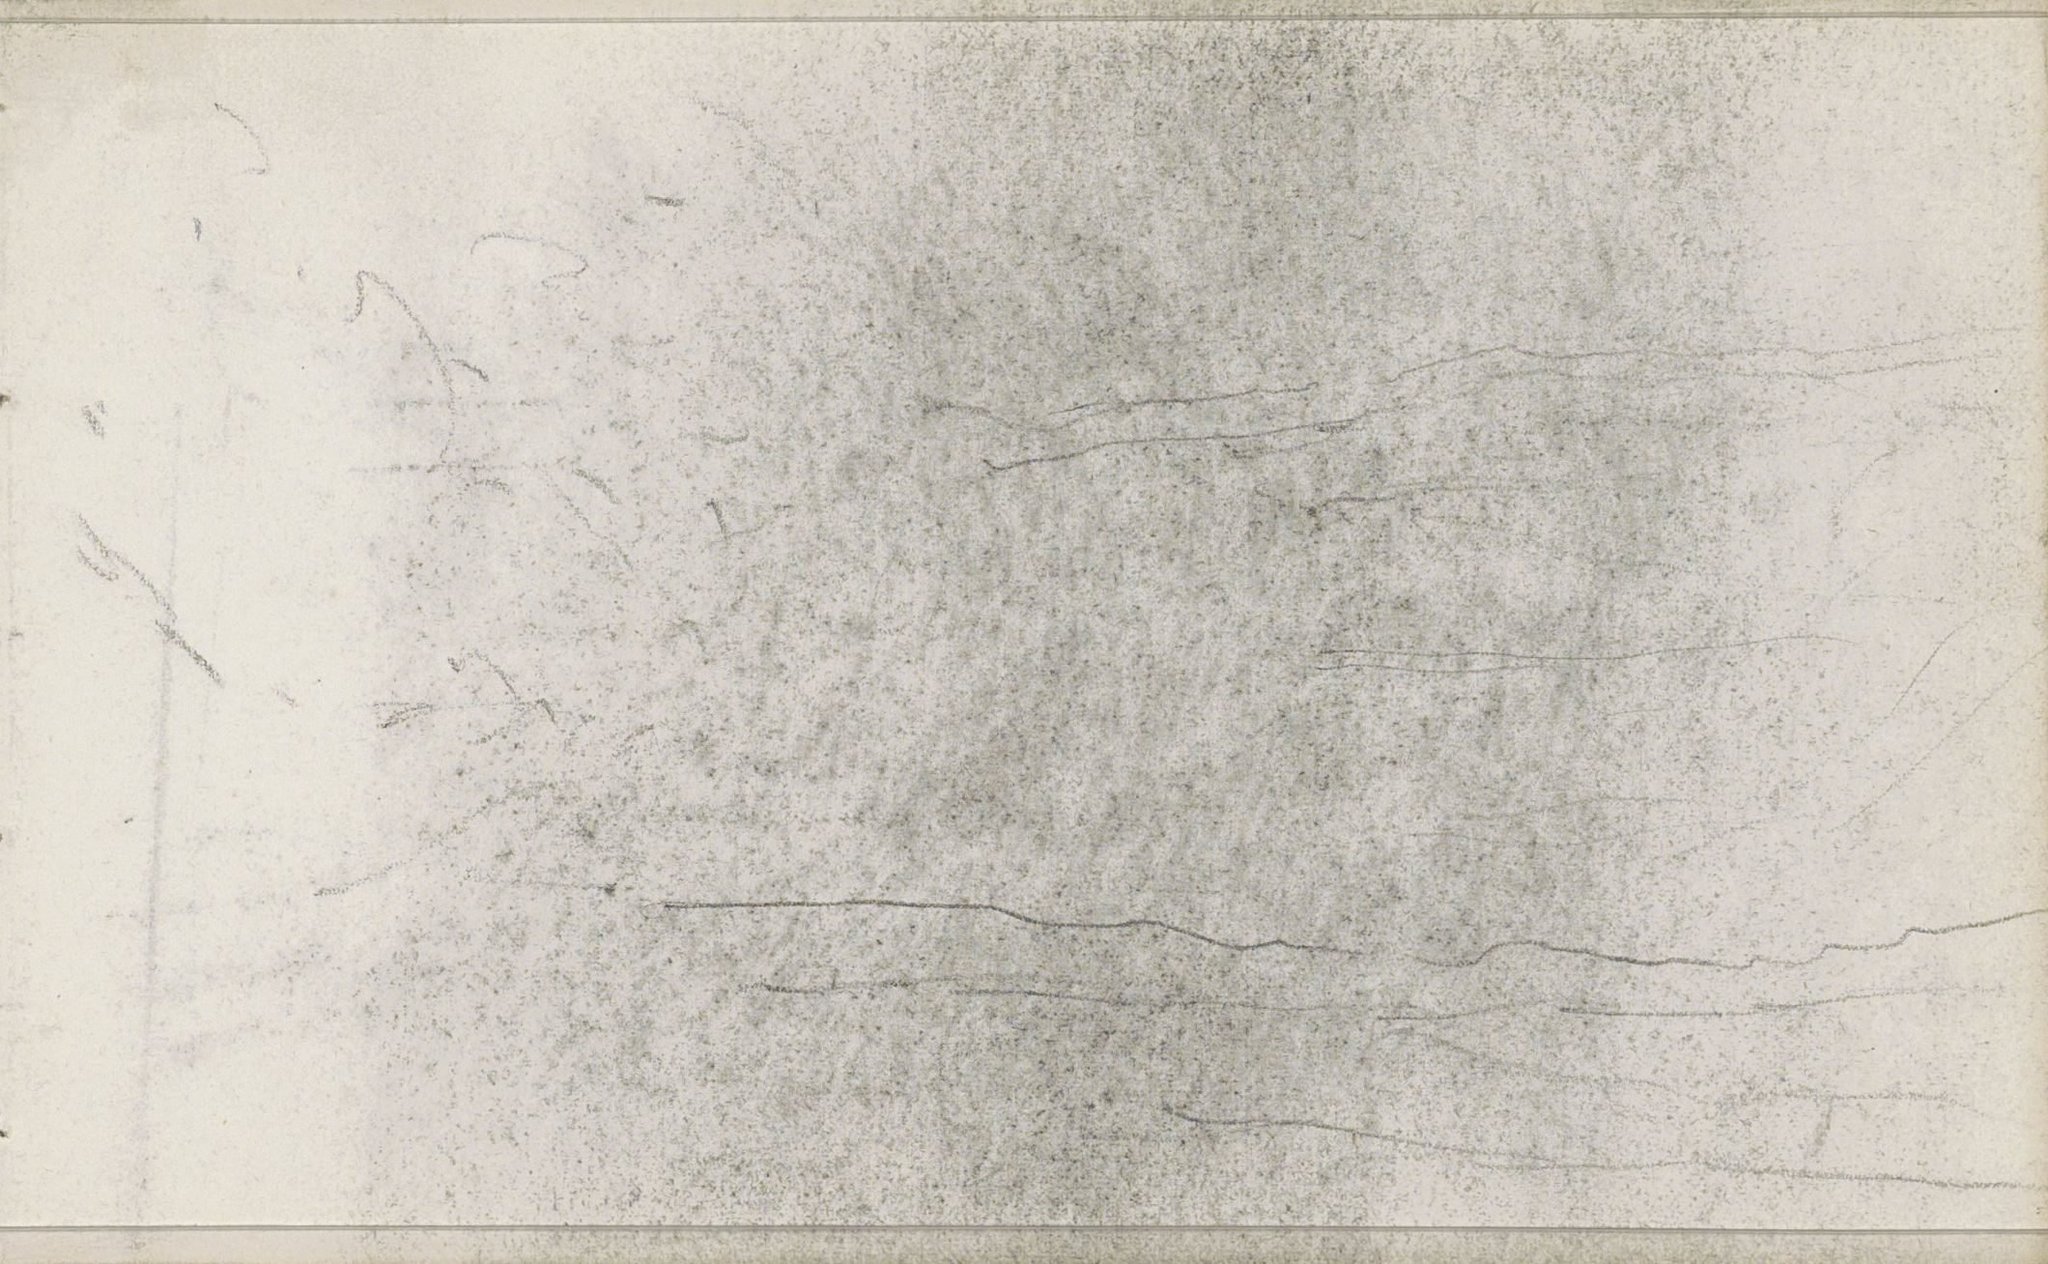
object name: sketchbook leaf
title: Boomstammen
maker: anton mauve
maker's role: draughtsman, painter, print maker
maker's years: 1838-1888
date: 1848-1888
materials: paper, pencil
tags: trees (+ stem, trunk)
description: Blad 20 recto uit een schetsboek met 43 bladen.